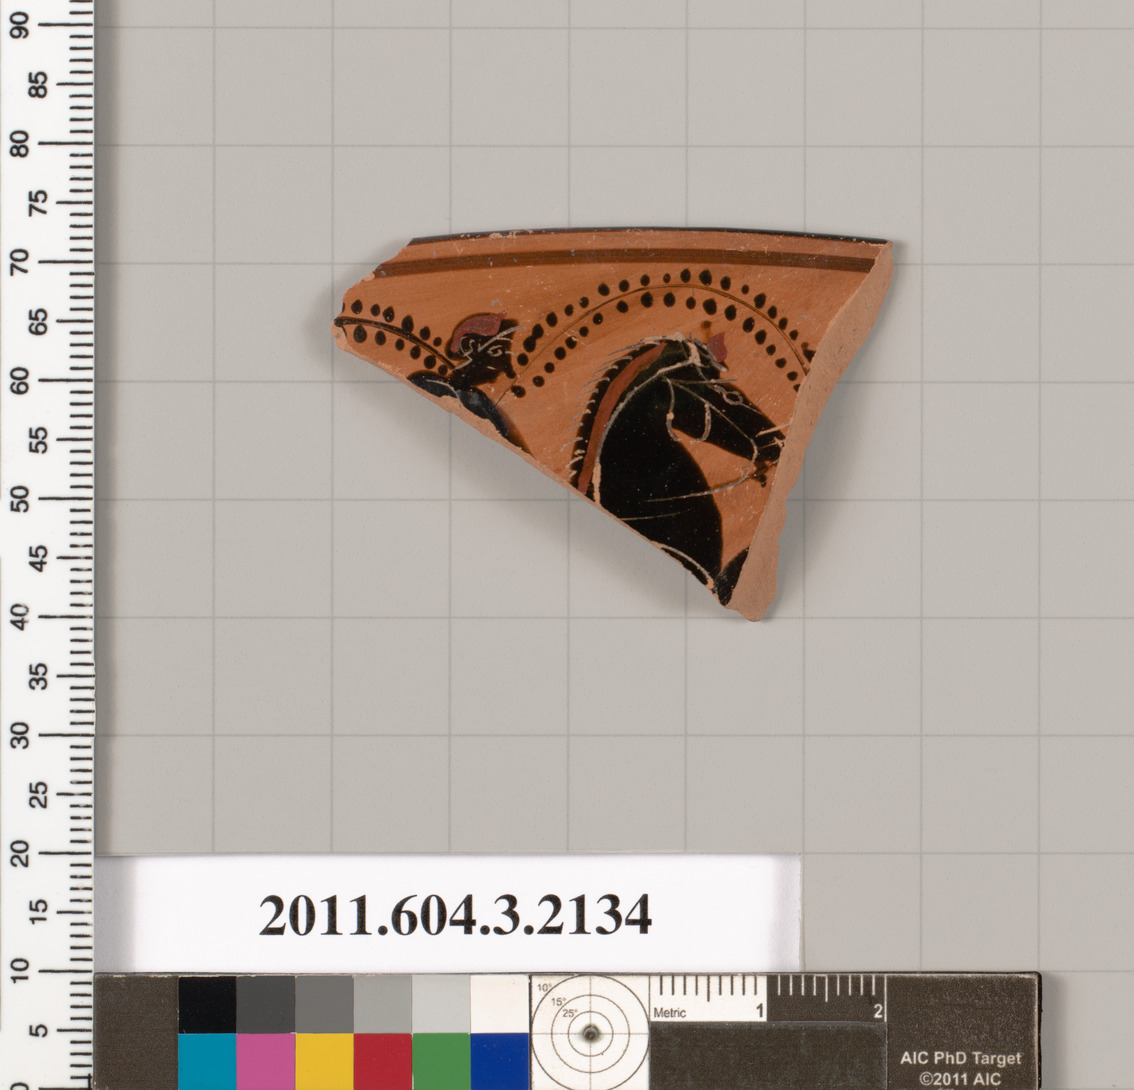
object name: kylix fragment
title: Terracotta rim fragment of a kylix (drinking cup)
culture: greek, attic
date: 525-501 BCE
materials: terracotta